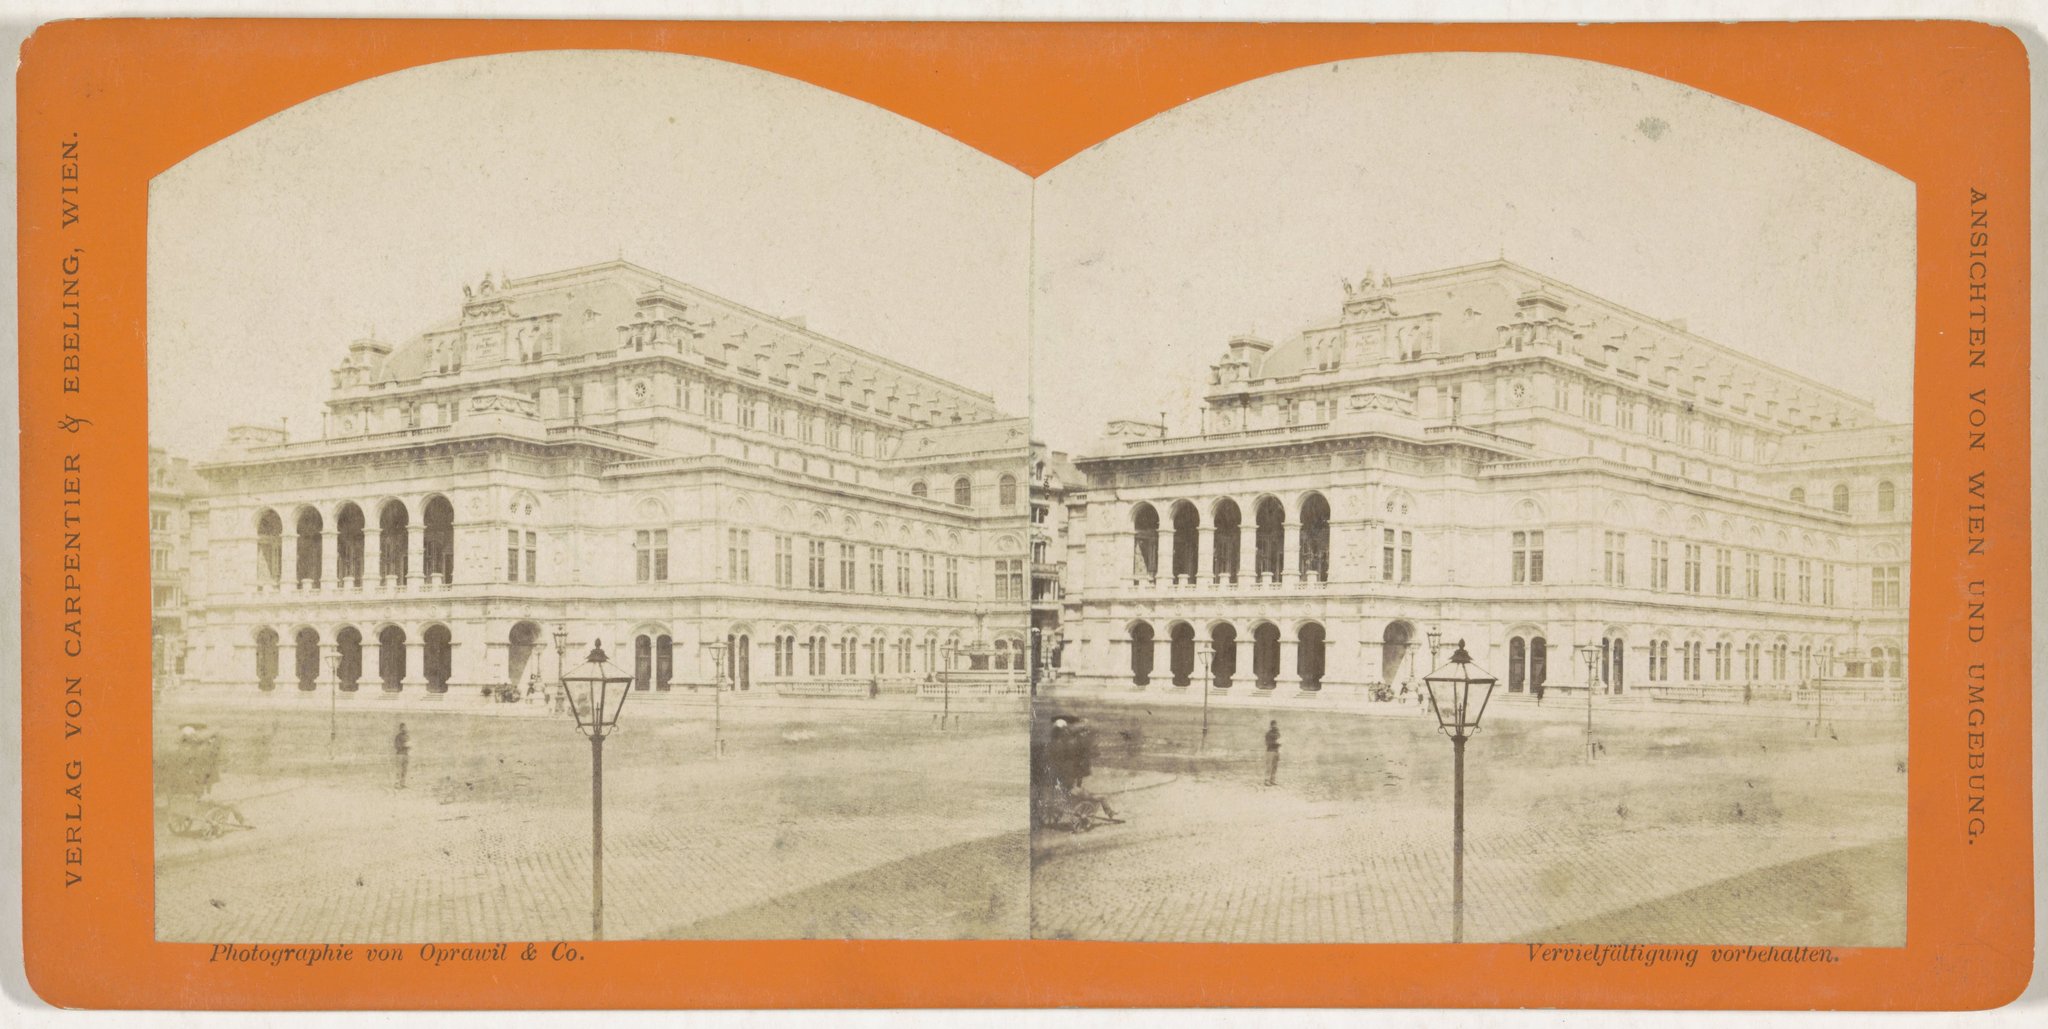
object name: stereograph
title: Das Neue Opernhaus. Nouvel opéra. - New opera-house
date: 1868-1880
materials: cardboard, paper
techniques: albumen print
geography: vienna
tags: opera house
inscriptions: inscription: ‘Vervielältigung vorbehalten.’, number: ‘5’